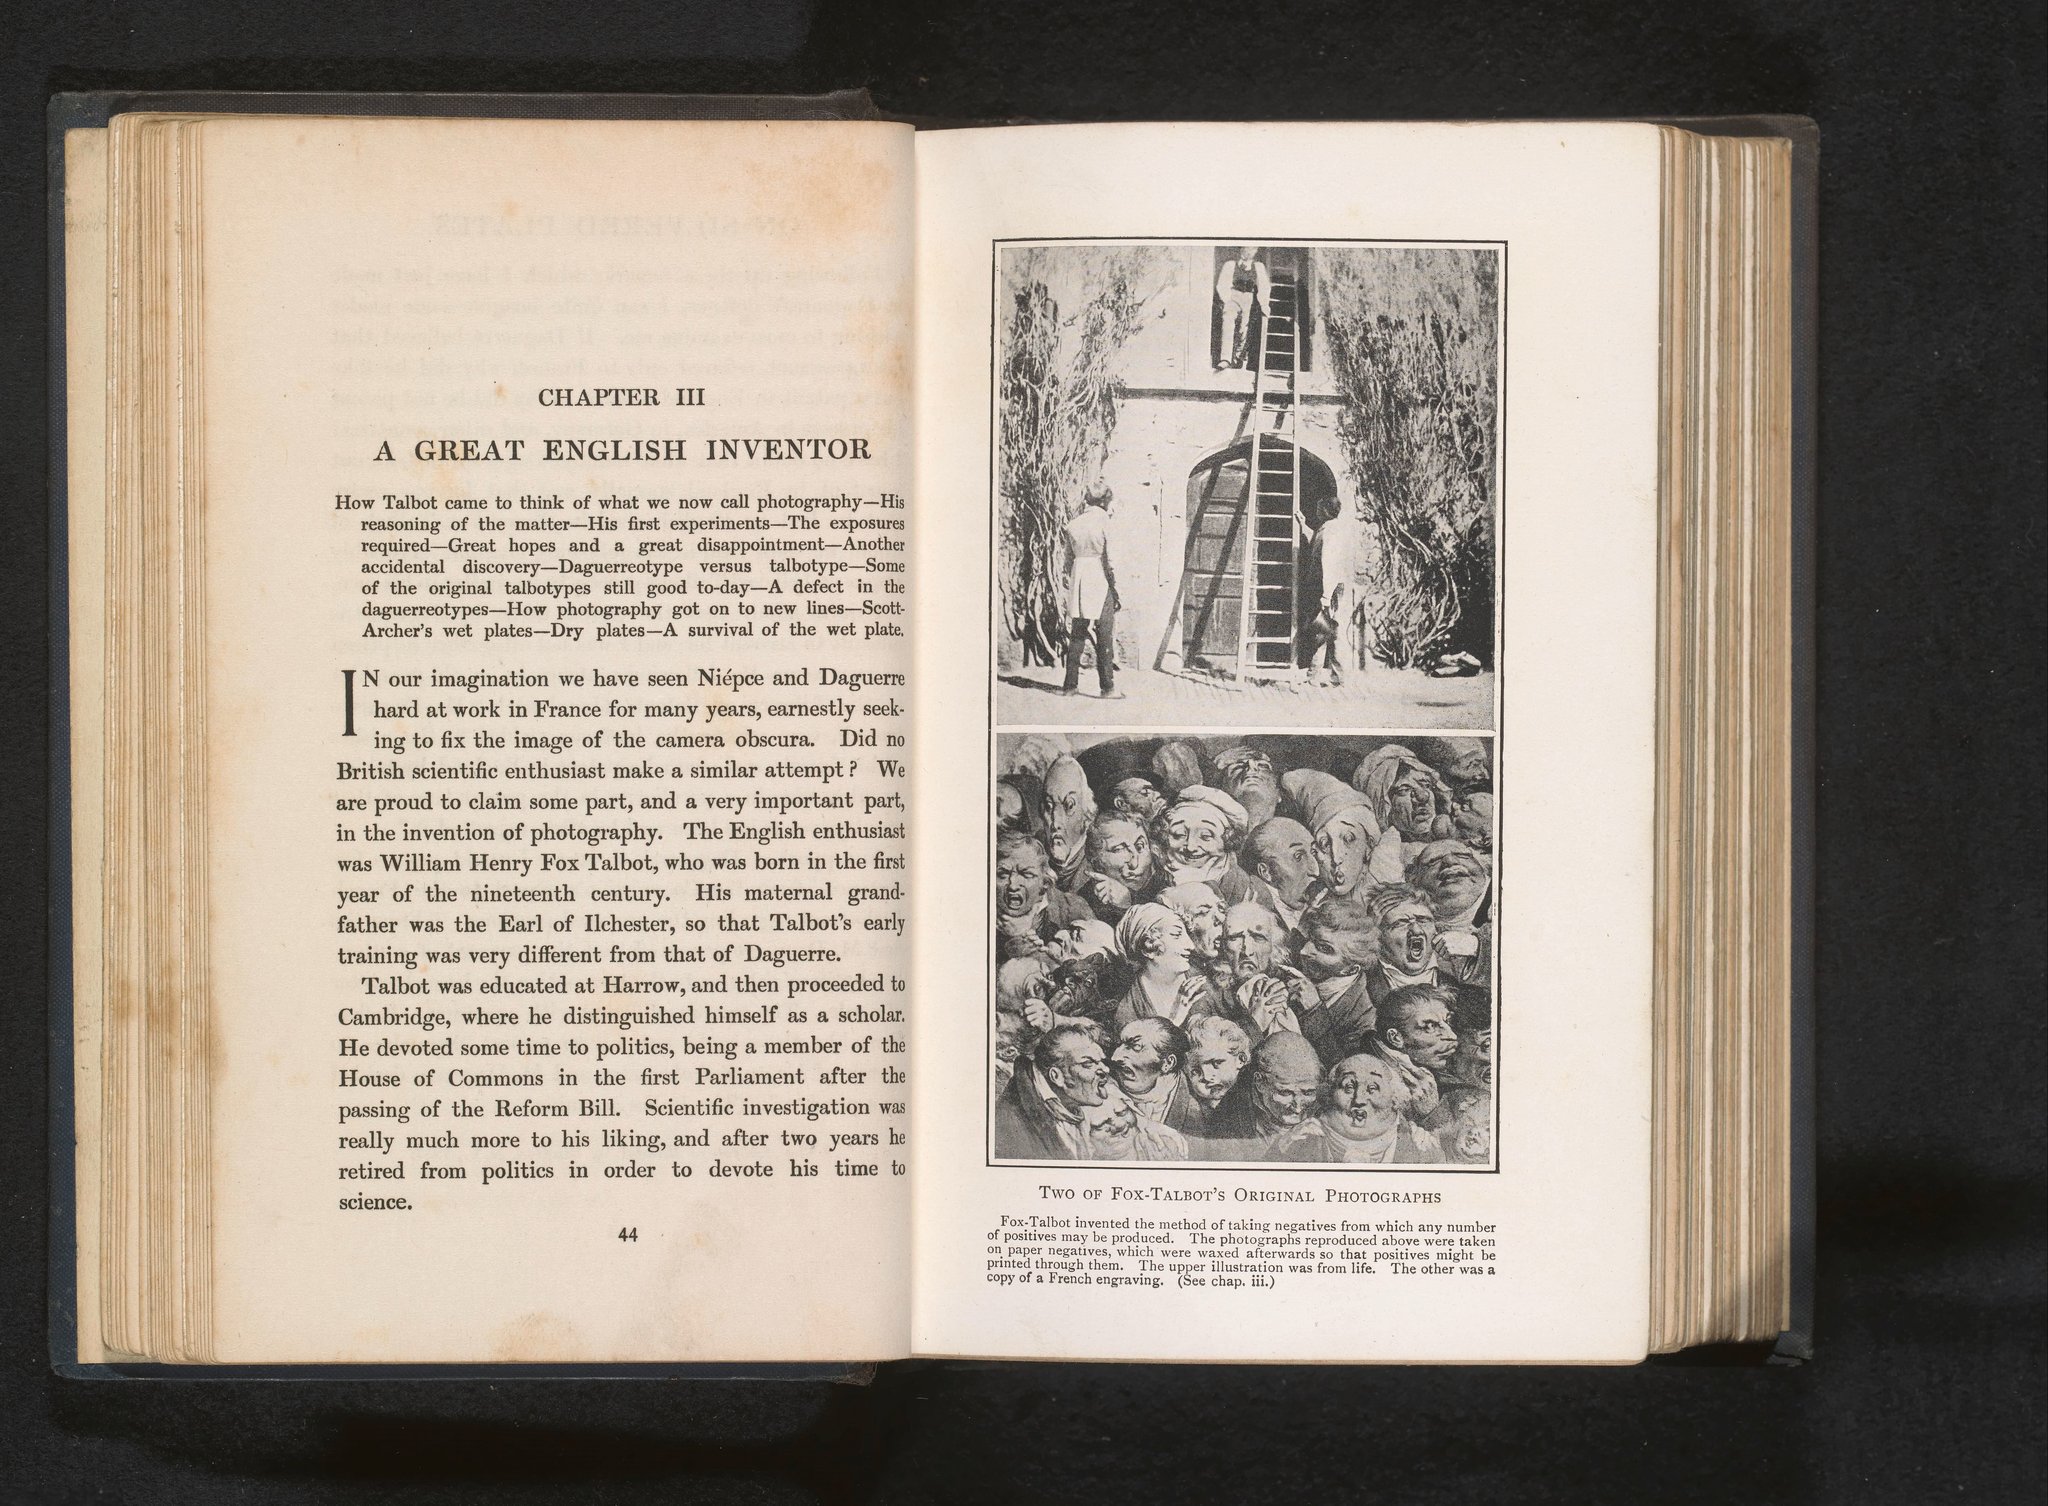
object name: page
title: Two of Fox-Talbot's original photographs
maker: Anonymous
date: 1898-1908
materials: paper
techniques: autotype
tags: print, e.g.: engraving, etching, lithograph, ladder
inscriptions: inscription: ‘Fox-Talbot invented the method of taking negatives from which any number of positives may be produced. The photographs reproduced above were taken on paper negatives, which were waxed afterwards so that the possitive might be printed through them. The upper illustration was from life. The other was a copy of a French engraving. (See chap. iii.)’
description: Boven drie mannen bij een huis met een ladder, onder een fotoreproductie van een prent van Louis Léopold Boilly met 35 hoofden.